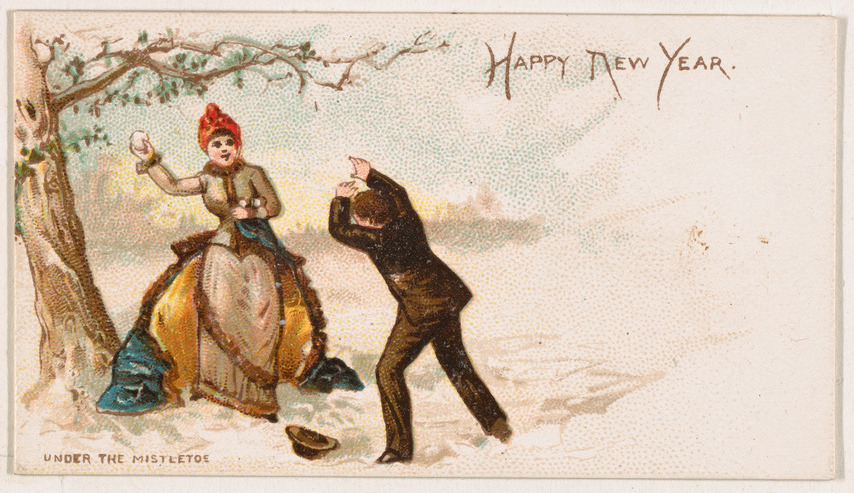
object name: print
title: Happy New Year, from the New Years 1890 series (N227) issued by Kinney Bros.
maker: kinney brothers tobacco company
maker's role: publisher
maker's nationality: american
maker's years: 1869-2011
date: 1889-1890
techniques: color lithograph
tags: men,women